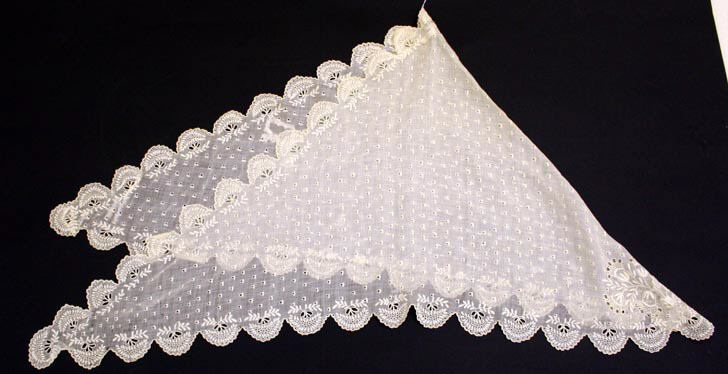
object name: fichu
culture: american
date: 1700-1942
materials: cotton